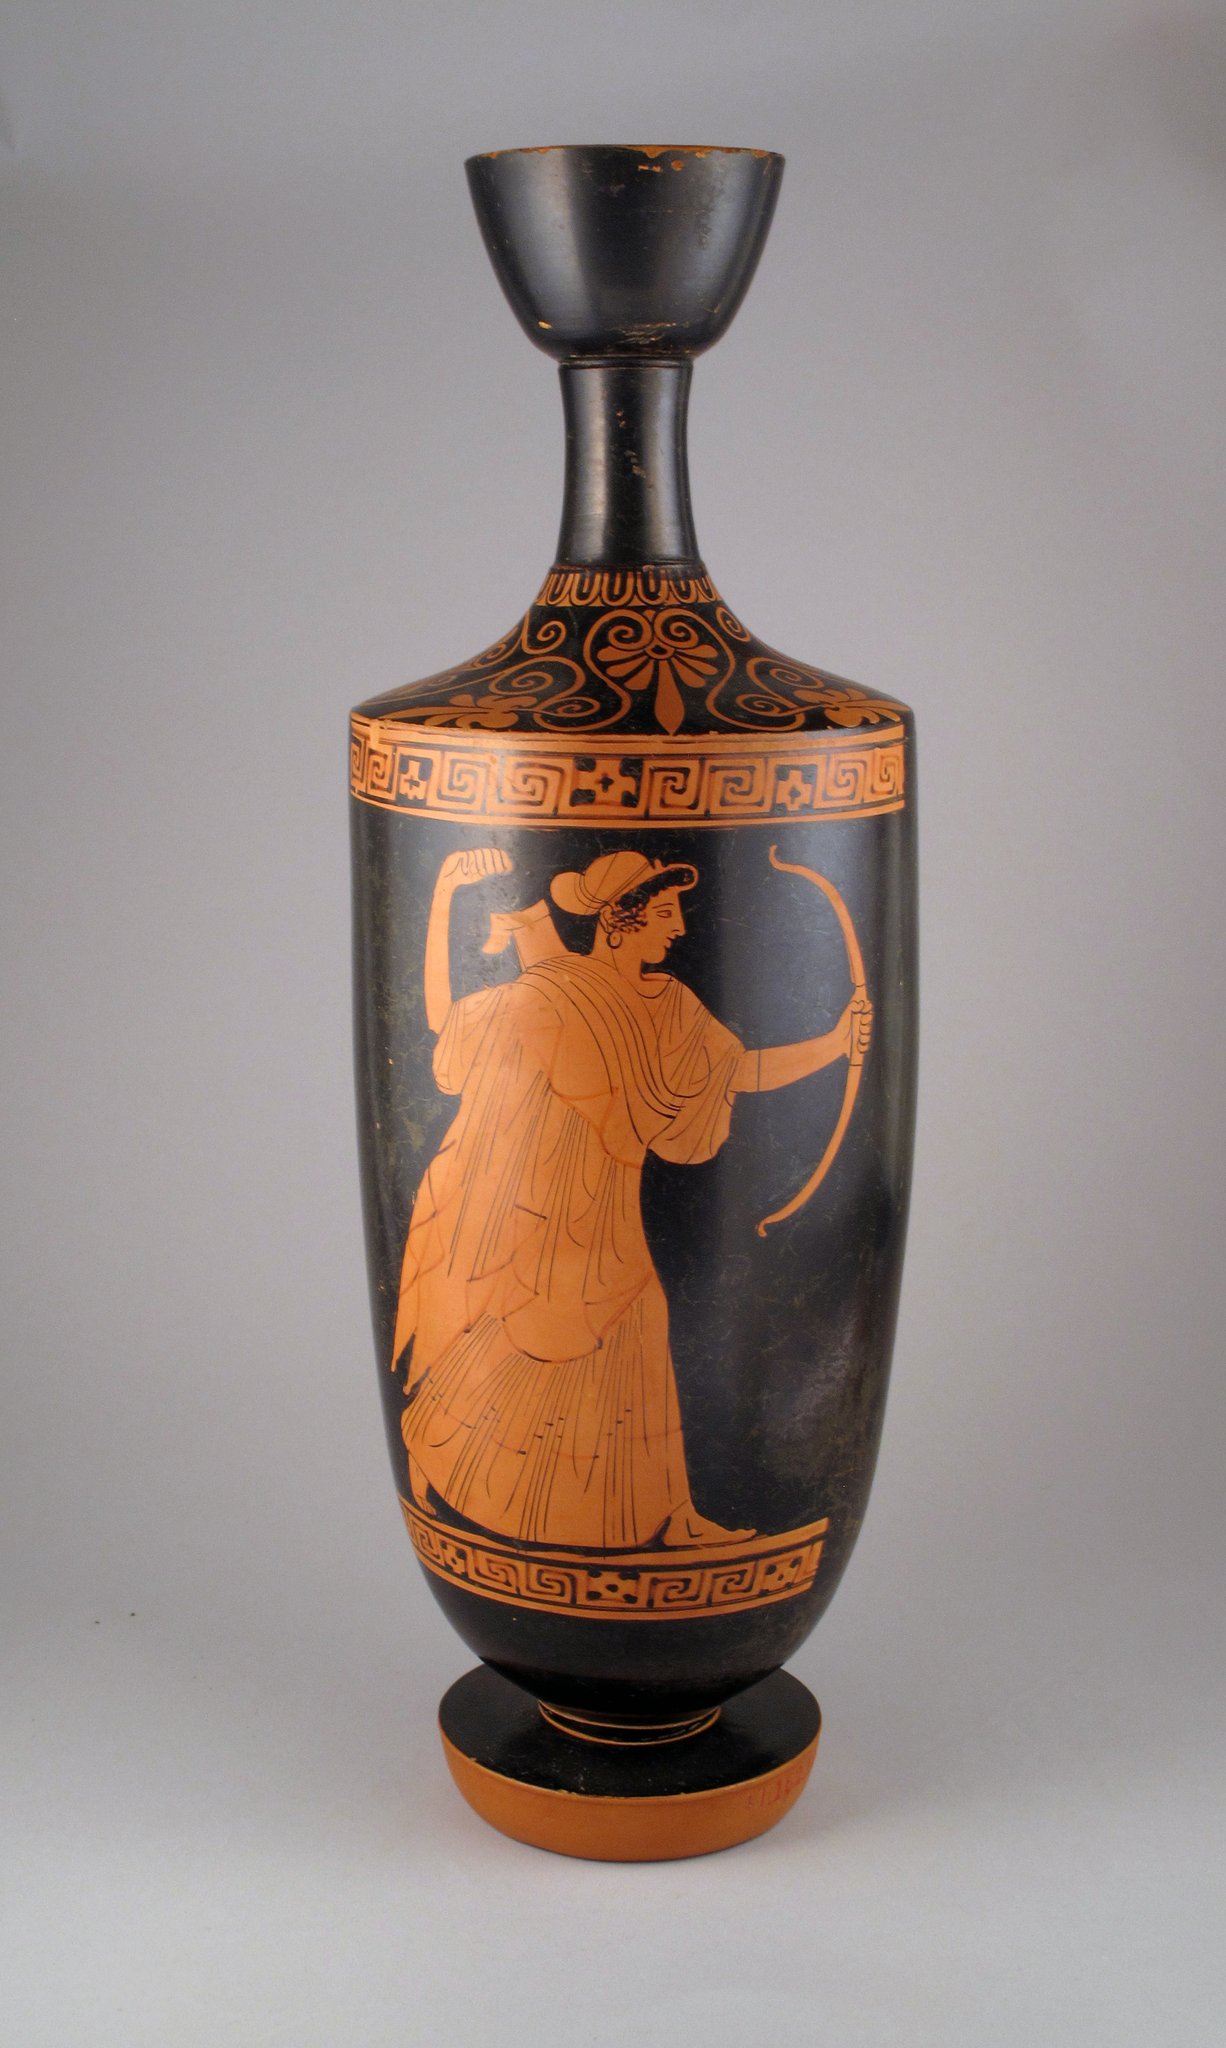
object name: lekythos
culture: greek, attic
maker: carlsruhe painter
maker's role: artist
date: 460-450 BCE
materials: terracotta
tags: bow and arrow,artemis